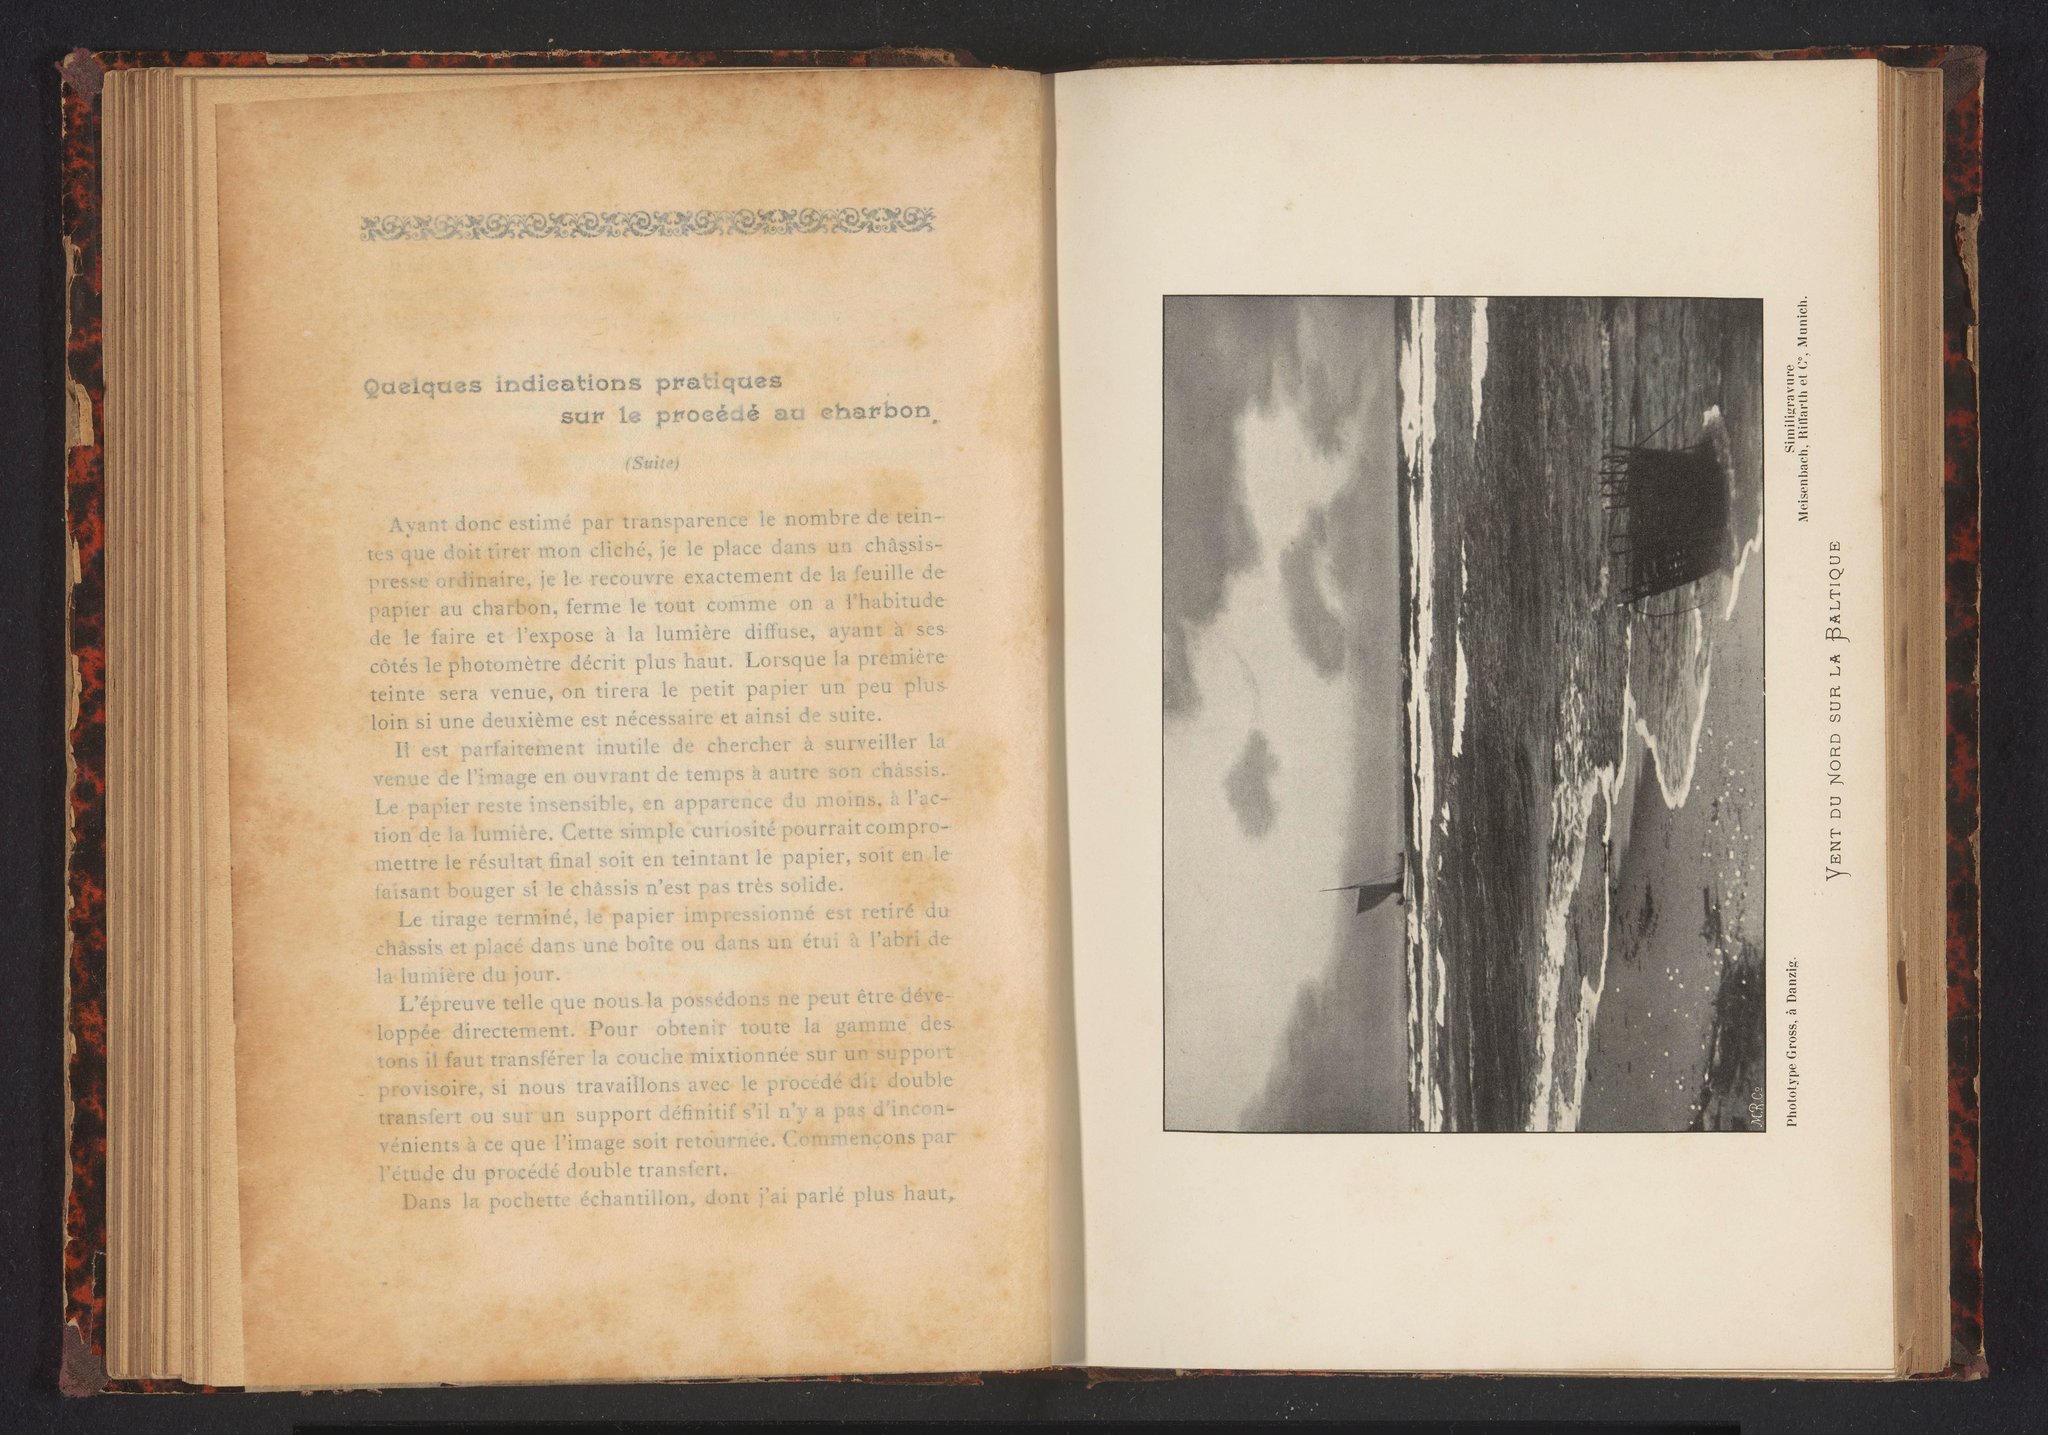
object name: photomechanical print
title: Gezicht op de Oostzee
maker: gross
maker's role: fotograaf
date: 1895-1900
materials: paper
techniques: autotype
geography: munich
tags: sailing-ship, sailing-boat, sea (seascape)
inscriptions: monogram: ‘M.R.Co’